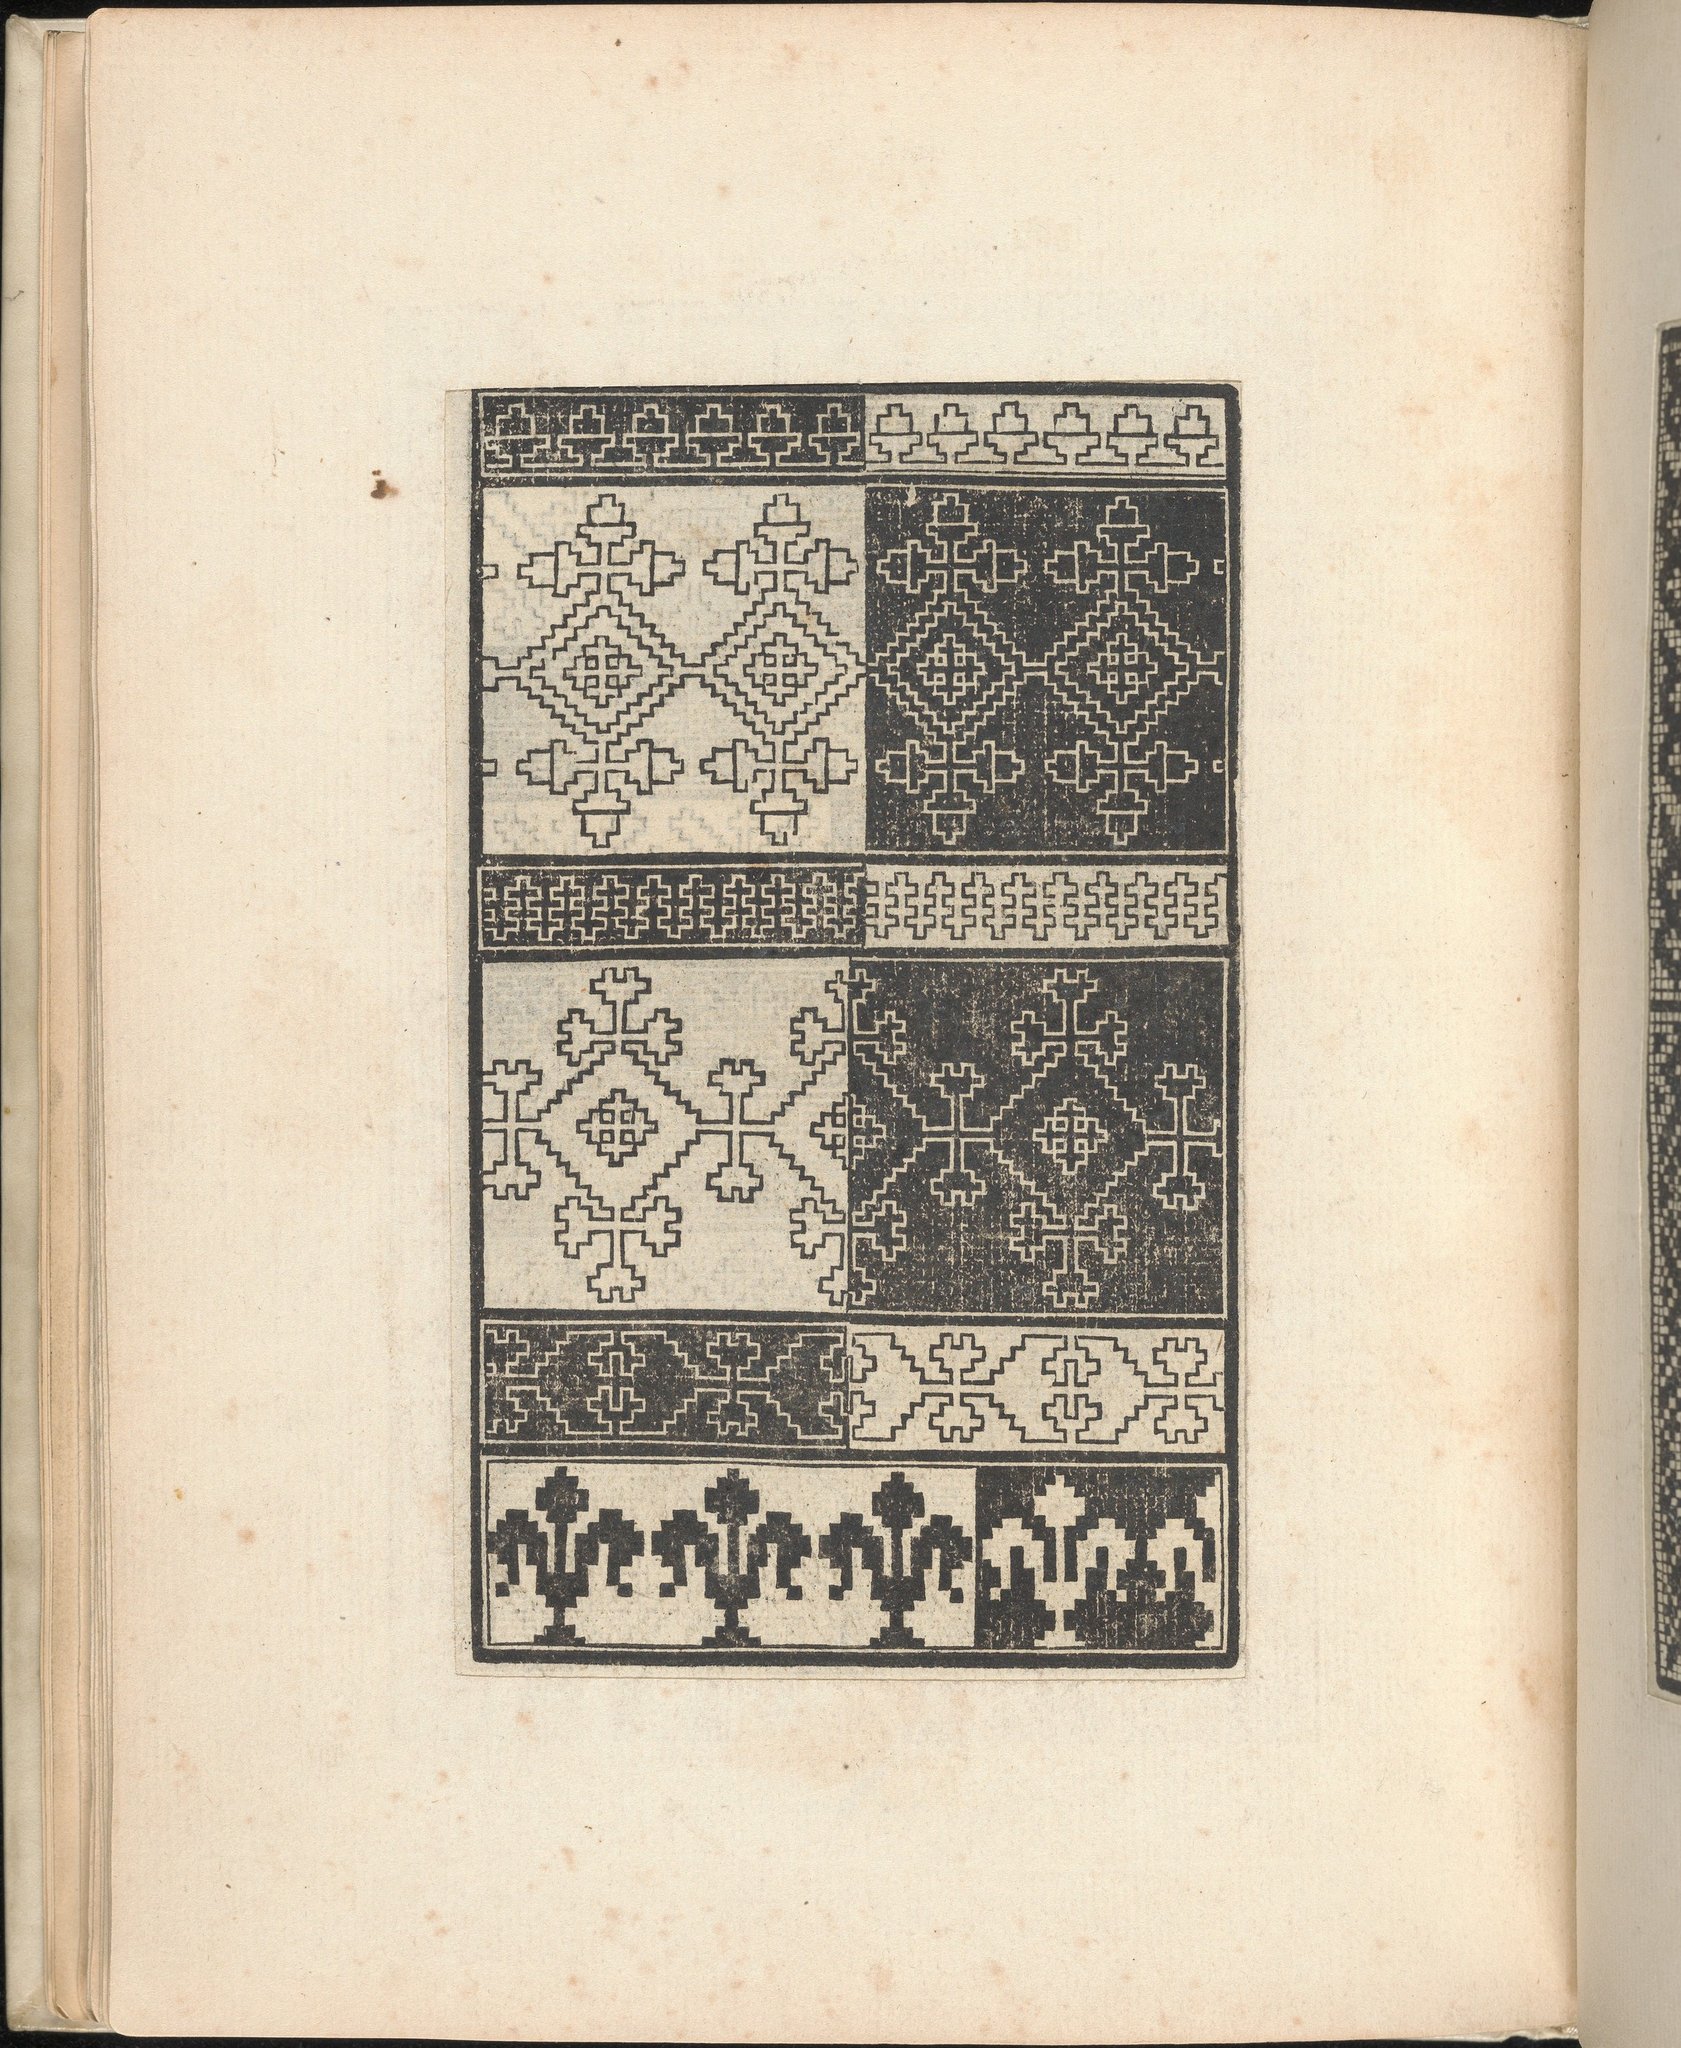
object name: book print ornament architecture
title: Esemplario di lavori, page 10 (verso)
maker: nicolò zoppino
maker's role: publisher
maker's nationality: italian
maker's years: 1478-1544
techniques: bookbinding, inlay, woodcut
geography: italy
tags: ornament